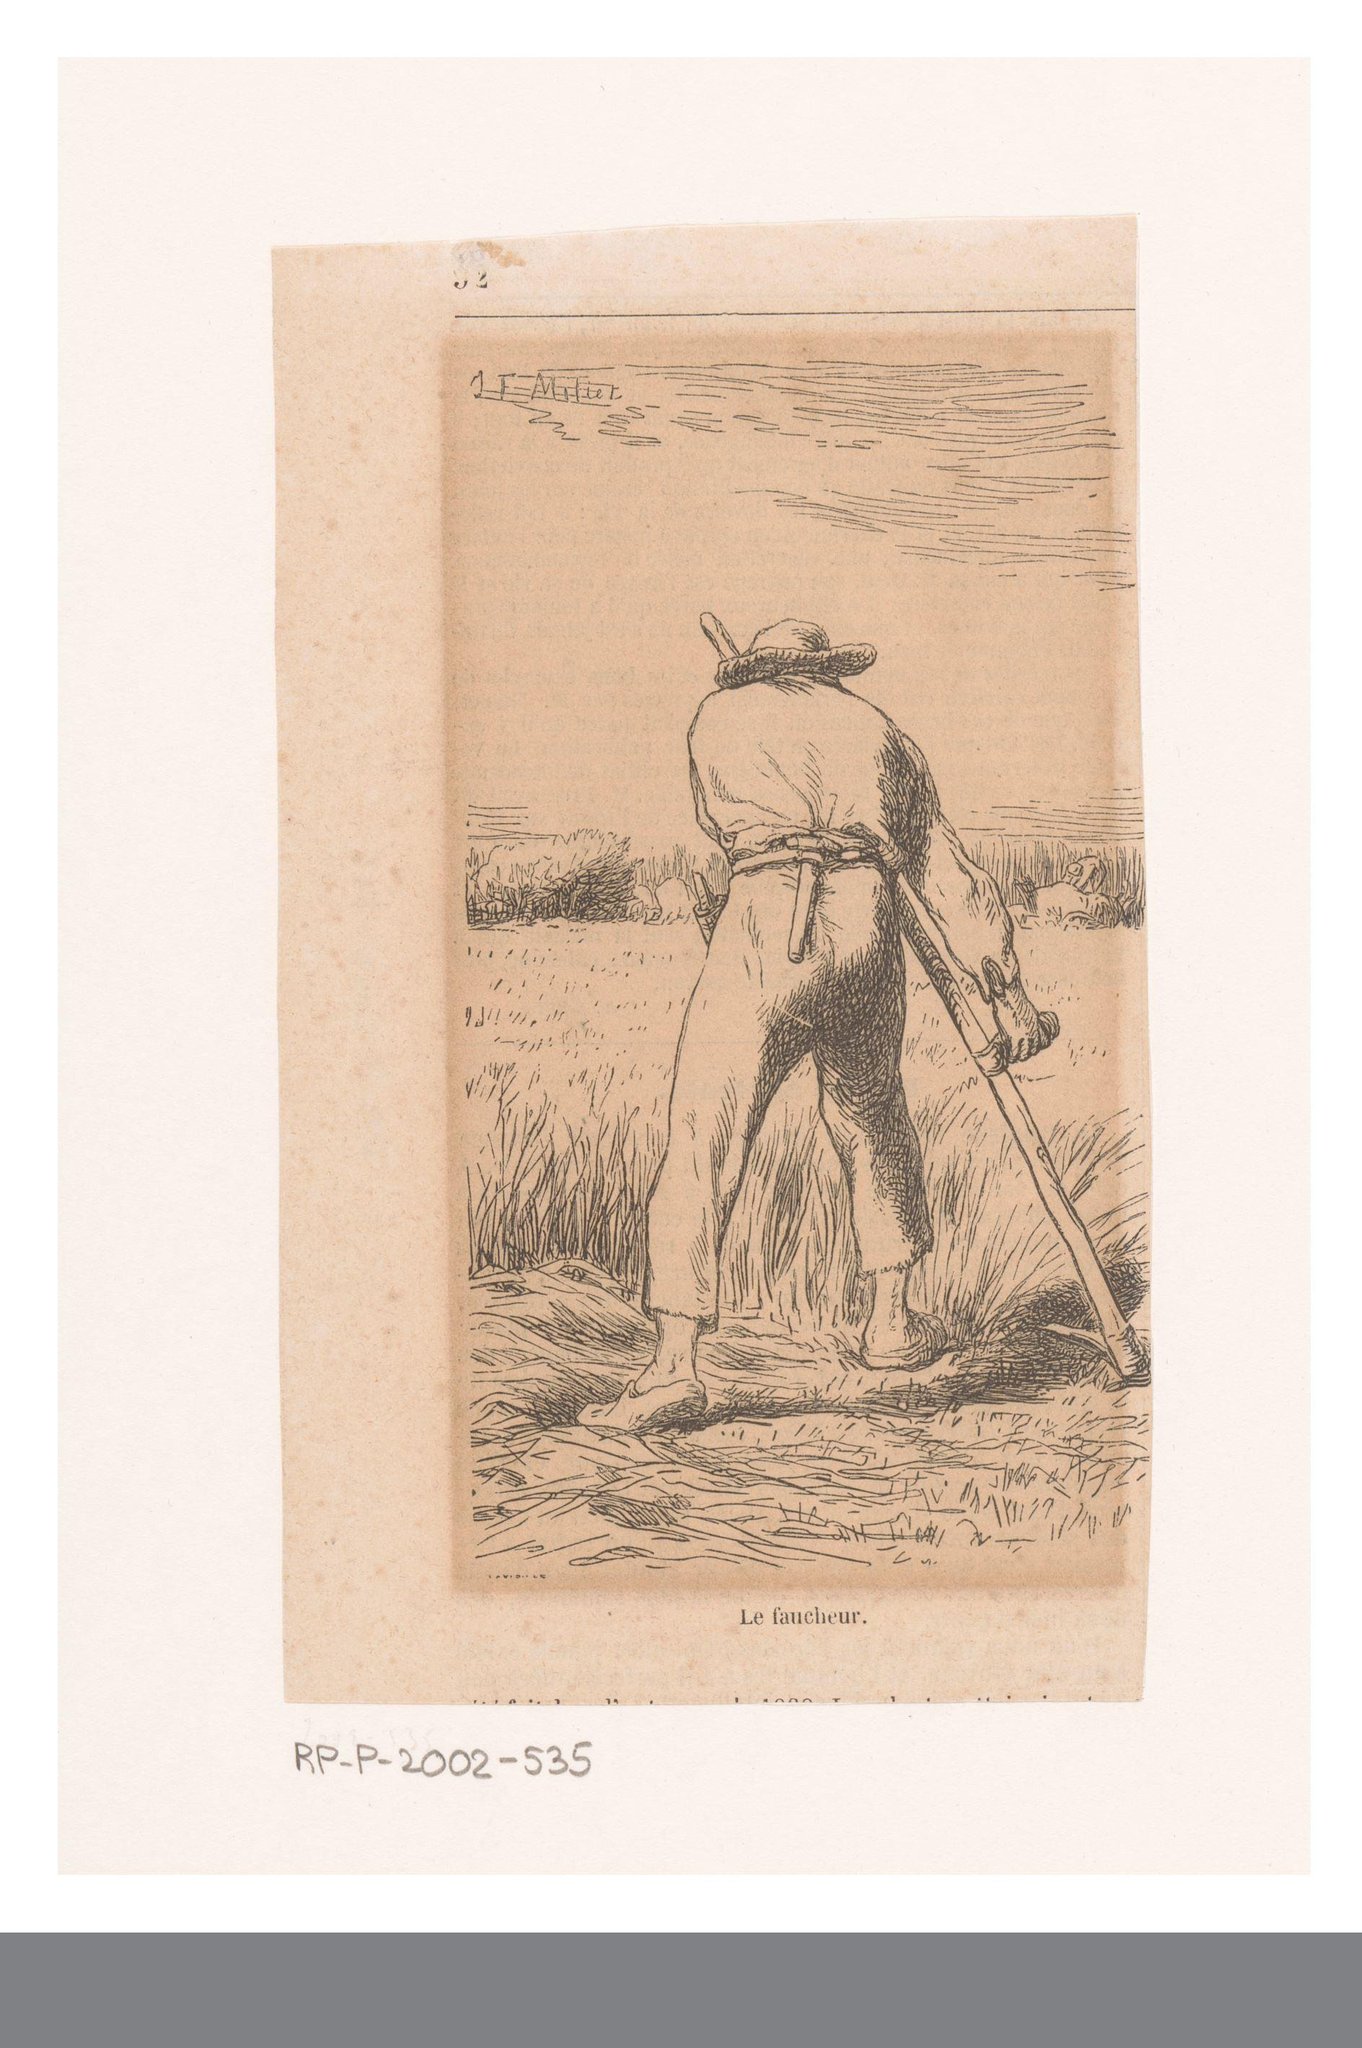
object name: print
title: Les Traveaux de Champs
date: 1853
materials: paper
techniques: engraving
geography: paris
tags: crafts and industries (+ agricultural processes), reaping, picking, mowing ~ harvest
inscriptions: collector's mark: Lugt 2228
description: Prent maakt deel uit van een serie van tien houtgravures gepubliceerd in 'L'Illustration' van 5 februari 1853, bij het artikel Revue Agricole van Saint-Germain Leduc.